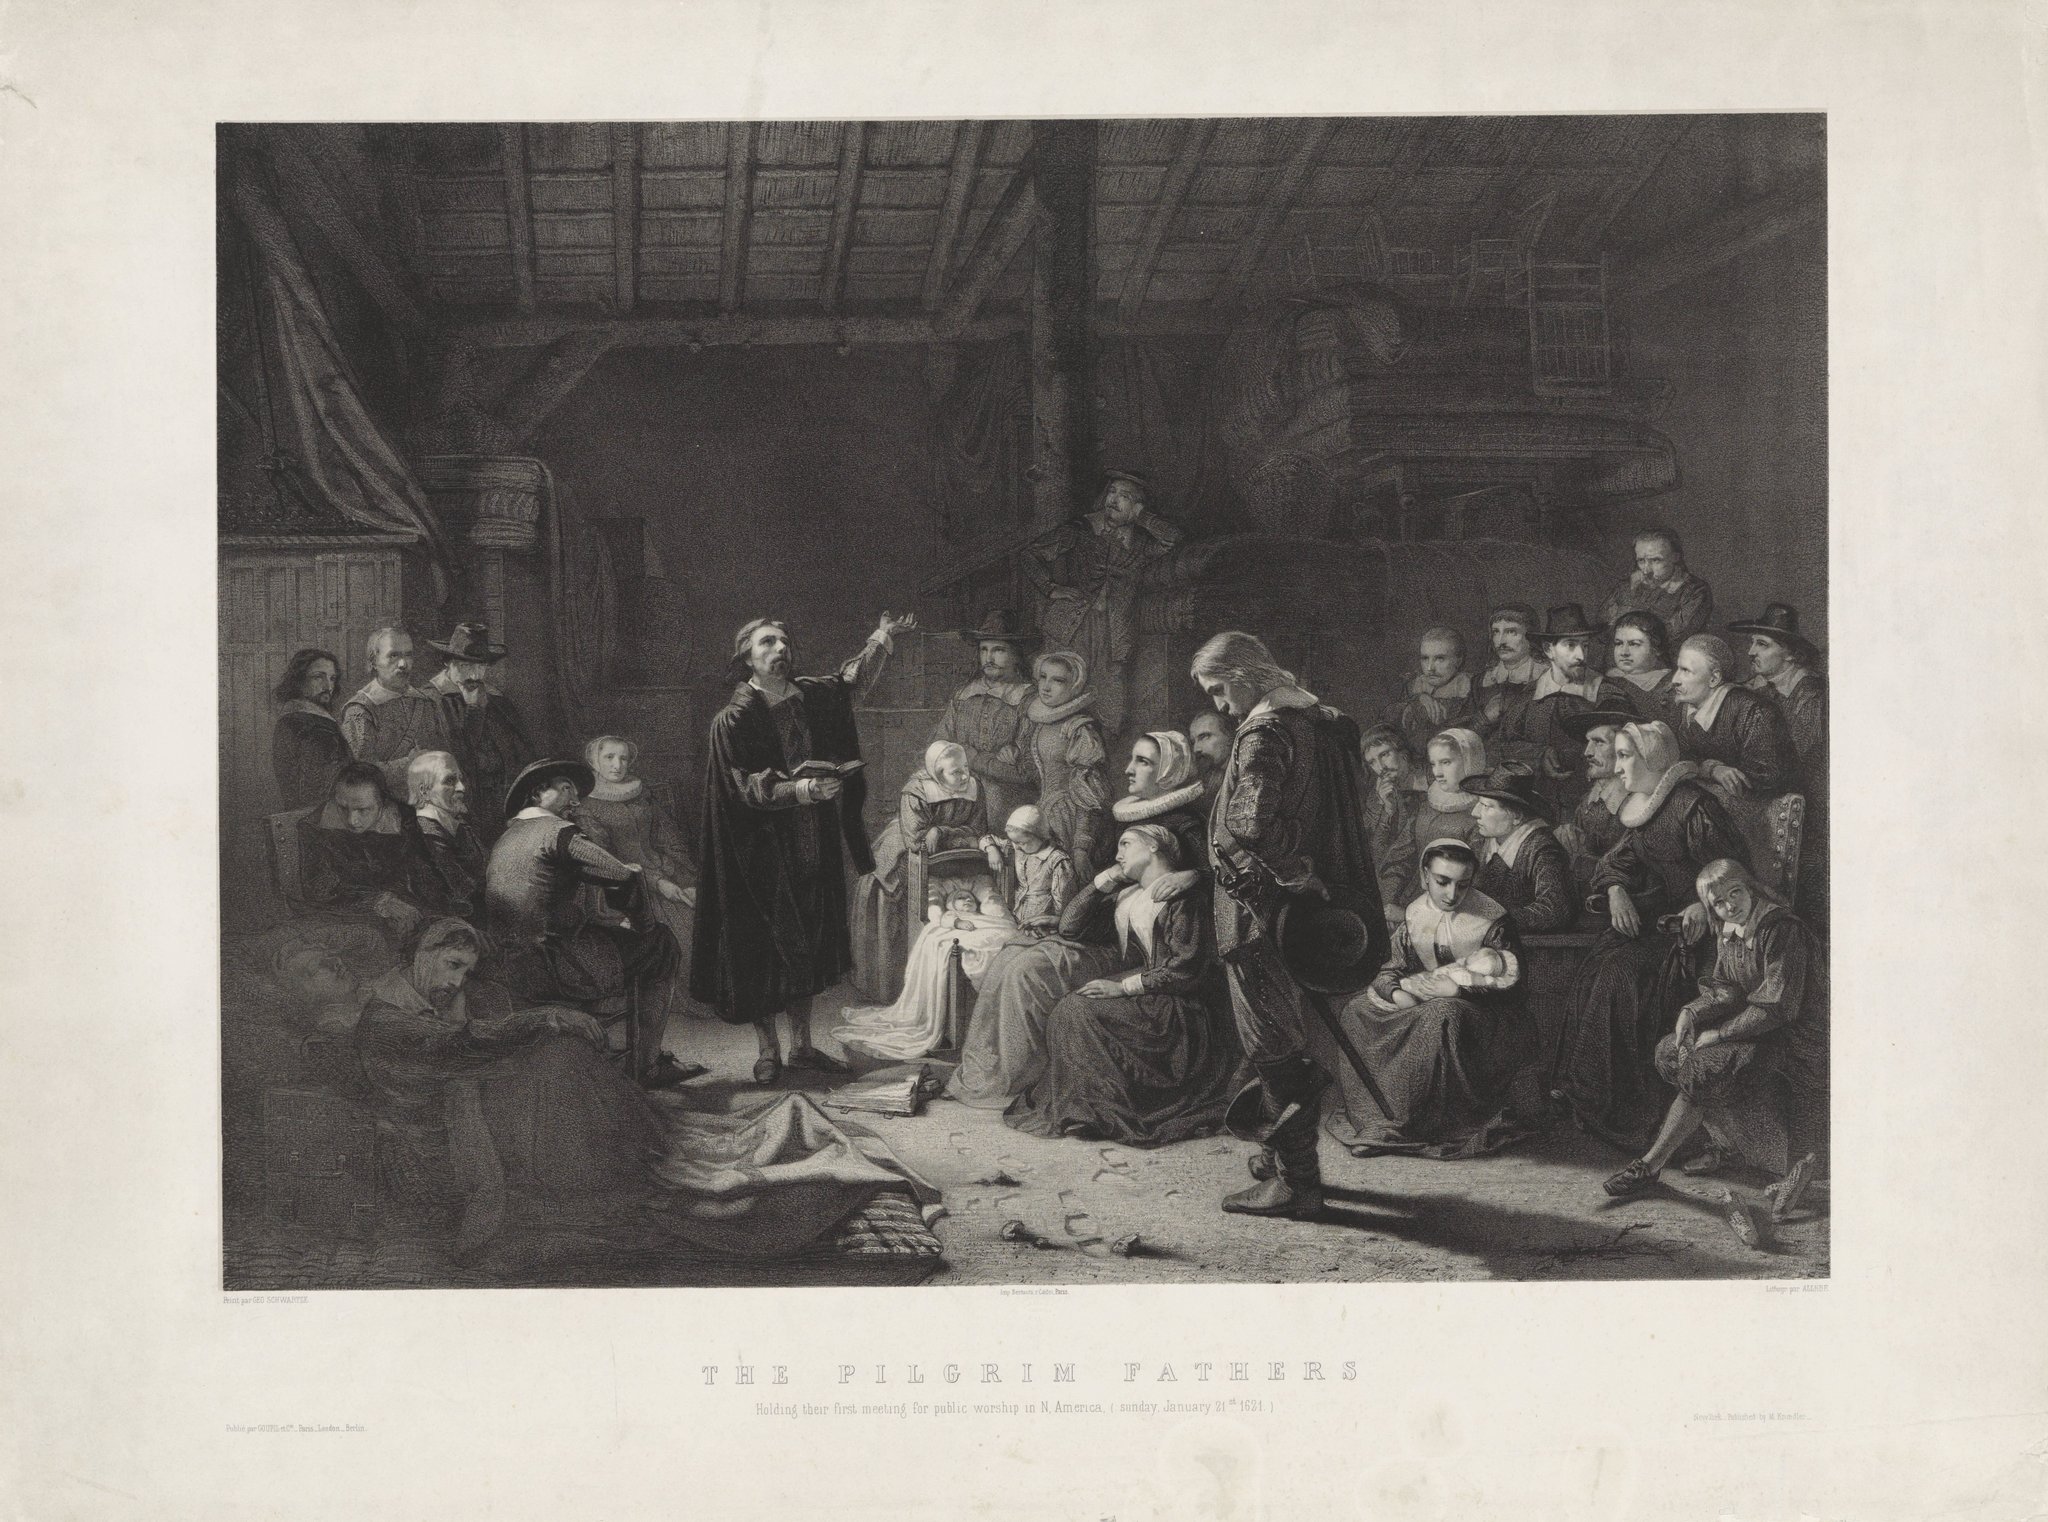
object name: print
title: Pilgrim Fathers op een bijeenkomst in Noord-Amerika, 21 januari 1621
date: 1857-1878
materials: paper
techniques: lithograph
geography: netherlands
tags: pilgrim(s), preaching (in general)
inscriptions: collector's mark: Lugt 2228, check stamp: Lugt 1090